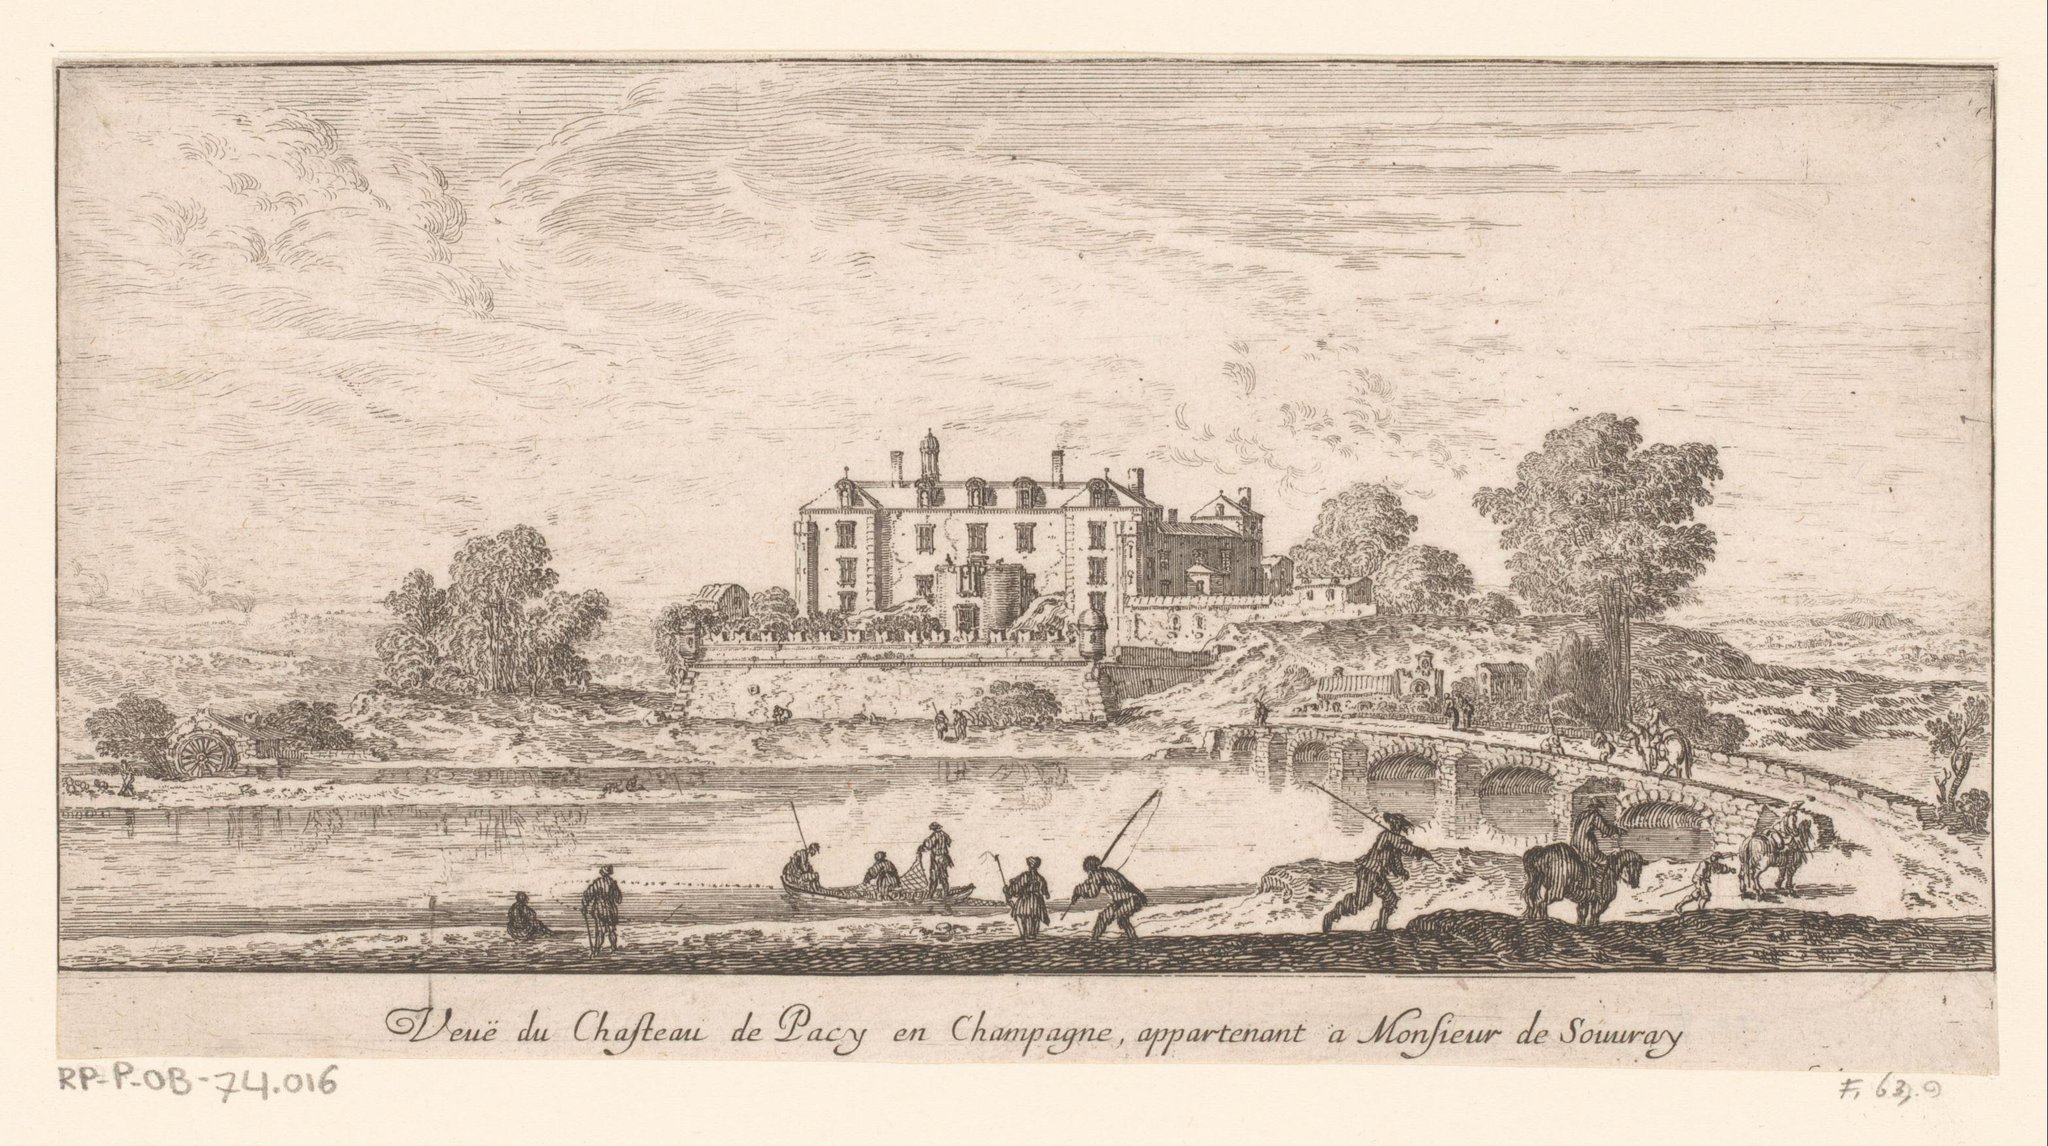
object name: print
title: Gezicht op kasteel Pacy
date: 1654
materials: paper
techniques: engraving, etching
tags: landscape with tower or castle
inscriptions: collector's mark: Lugt 240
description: Prent maakt deel uit van een ongenummerde serie van 21 prenten.